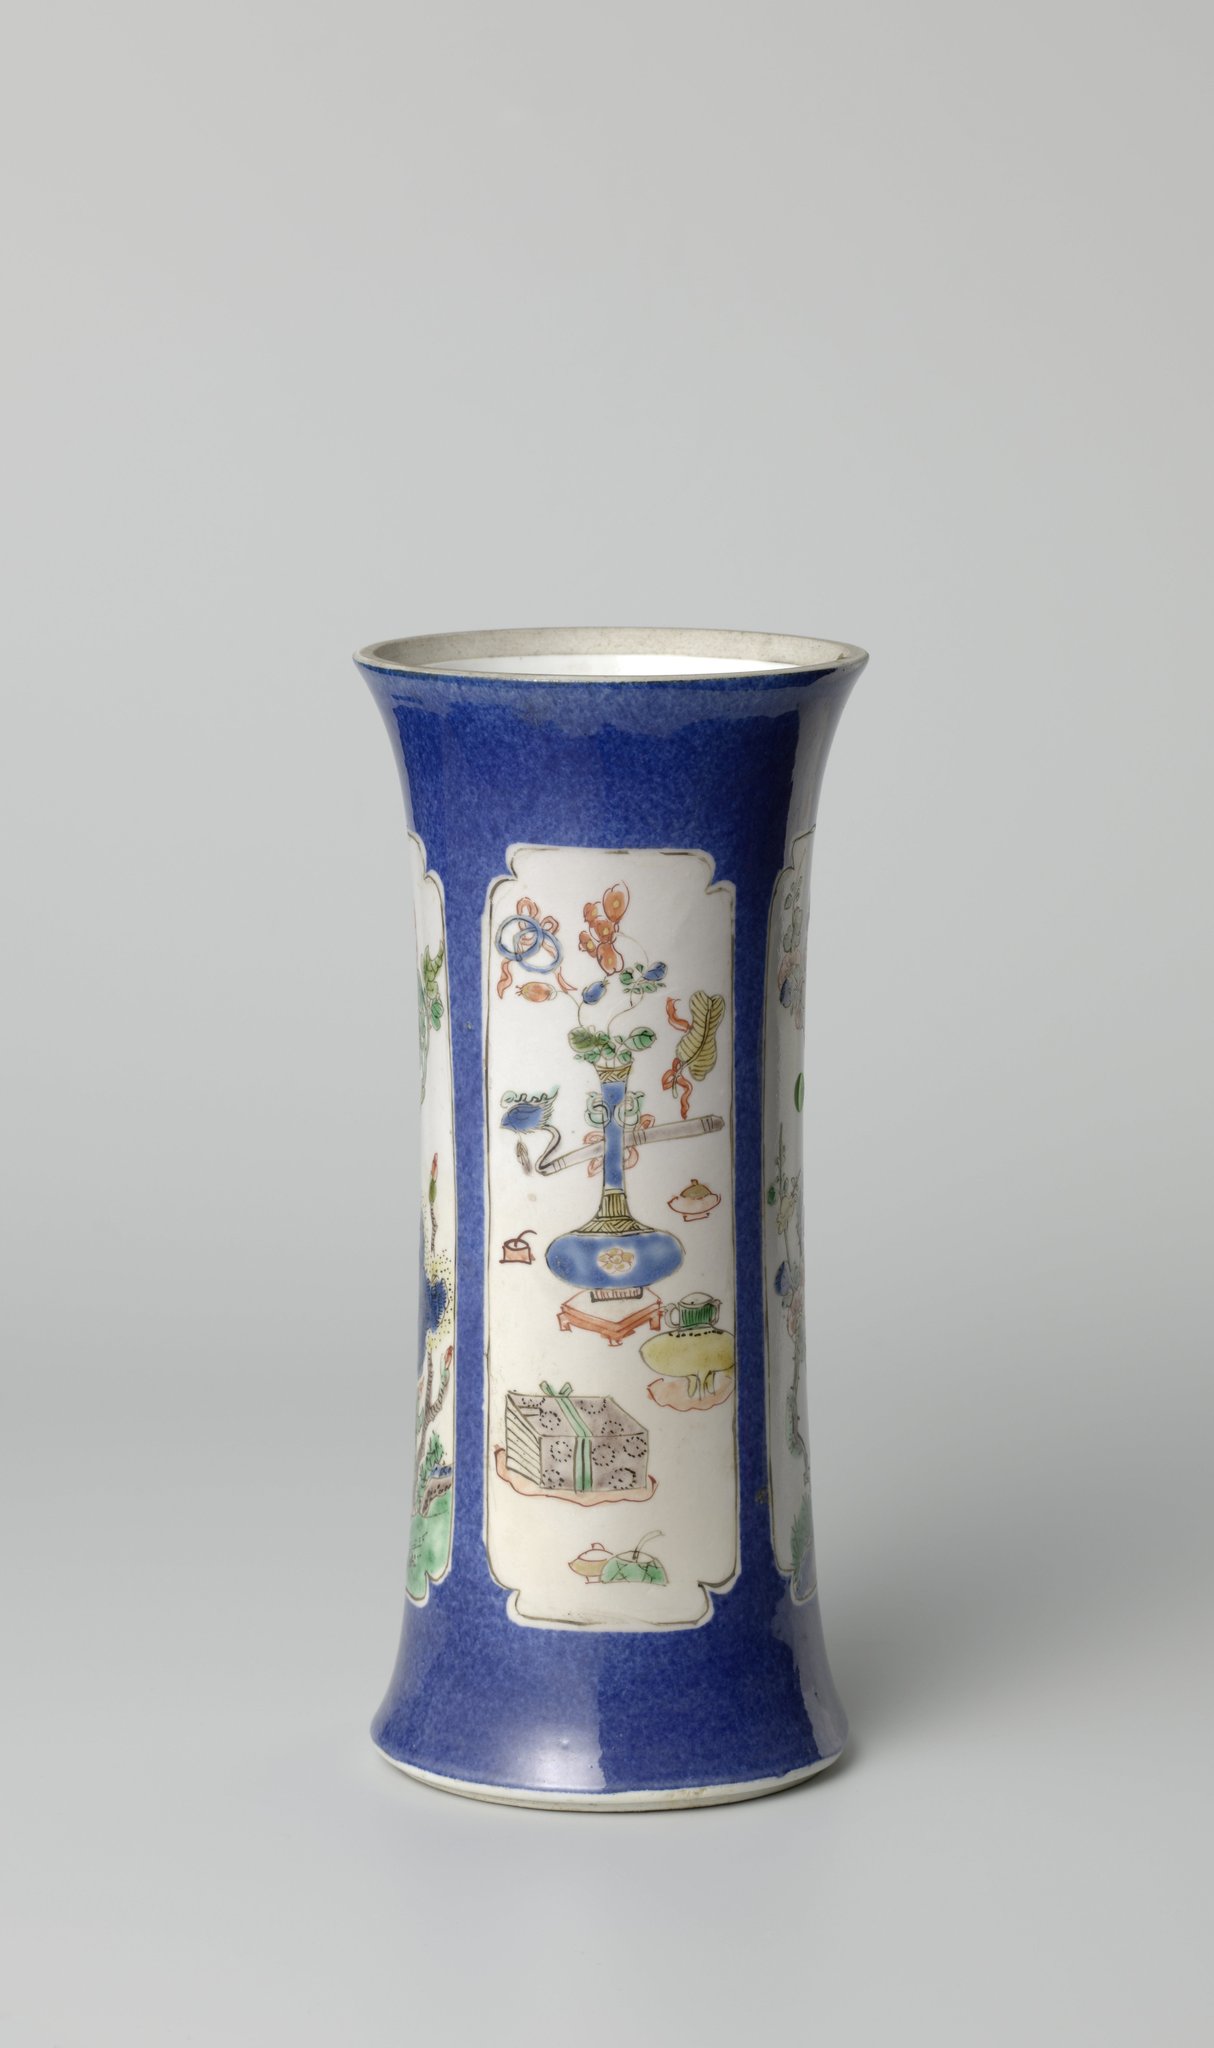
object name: vase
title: Beaker vase with powder blue, flower sprays, antiquities and precious objects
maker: Anonymous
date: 1700-1724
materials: cobalt, glaze, paint, porcelain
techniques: firing, turning, vitrification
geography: china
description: AK-NM-6363 twee bekers • Bleu poudré-porselein met verte • Onderdeel van Royers porseleincollectie • Mogelijk afkomstig van Susanna Louise Huygens Deze bekers, waarvan de deksels helaas ontbreken, vormen een kaststel met de dekselvaas AK-NM-6364. Zie ook de toelichting daar. De snelheid waarmee deze bekers zijn beschilderd, blijkt onder meer uit de verticale velden die soms niet recht in het vlak staan (-A). Bovendien zijn A en B net een beetje anders beschilderd. Dit hoeft geen bezwaar te zijn (kan zelfs een aanbeveling zijn), maar als men dit vergelijkt met de vazen AK-NM-6368 dan ziet men dat daar met uiterste precieze in elk vak hetzelfde patroon is geschilderd. Met meer aandacht en meer tijd.